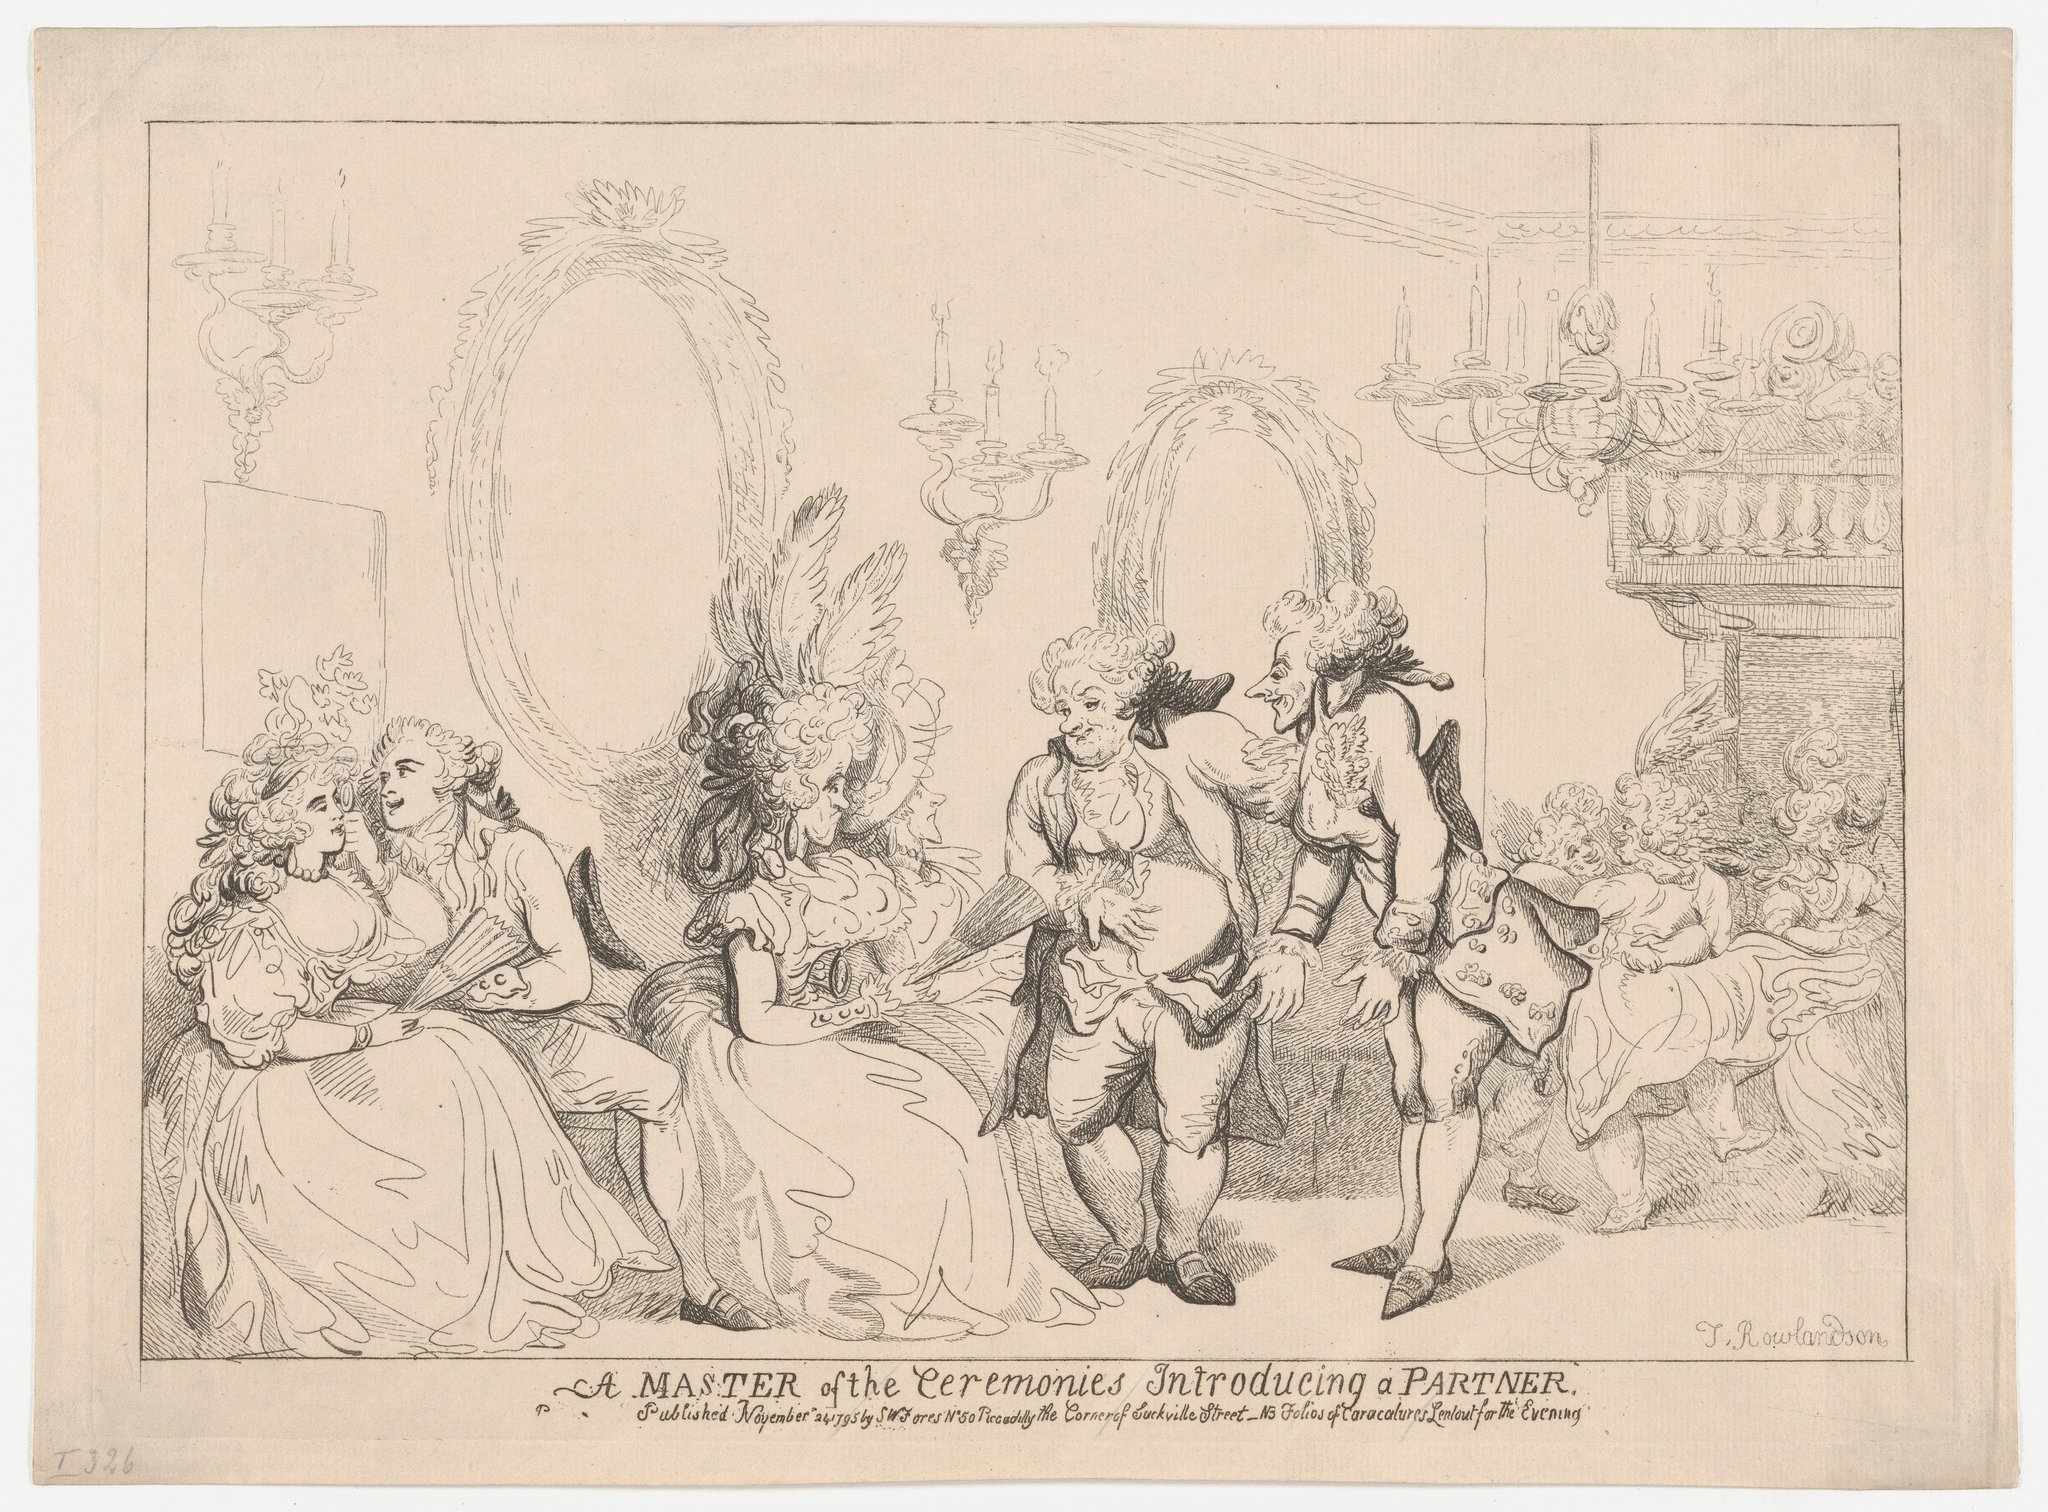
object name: print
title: A Master of Ceremonies Introducing a Partner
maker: thomas rowlandson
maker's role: artist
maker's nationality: british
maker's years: 1757-1827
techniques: etching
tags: satire,men,women,dancing